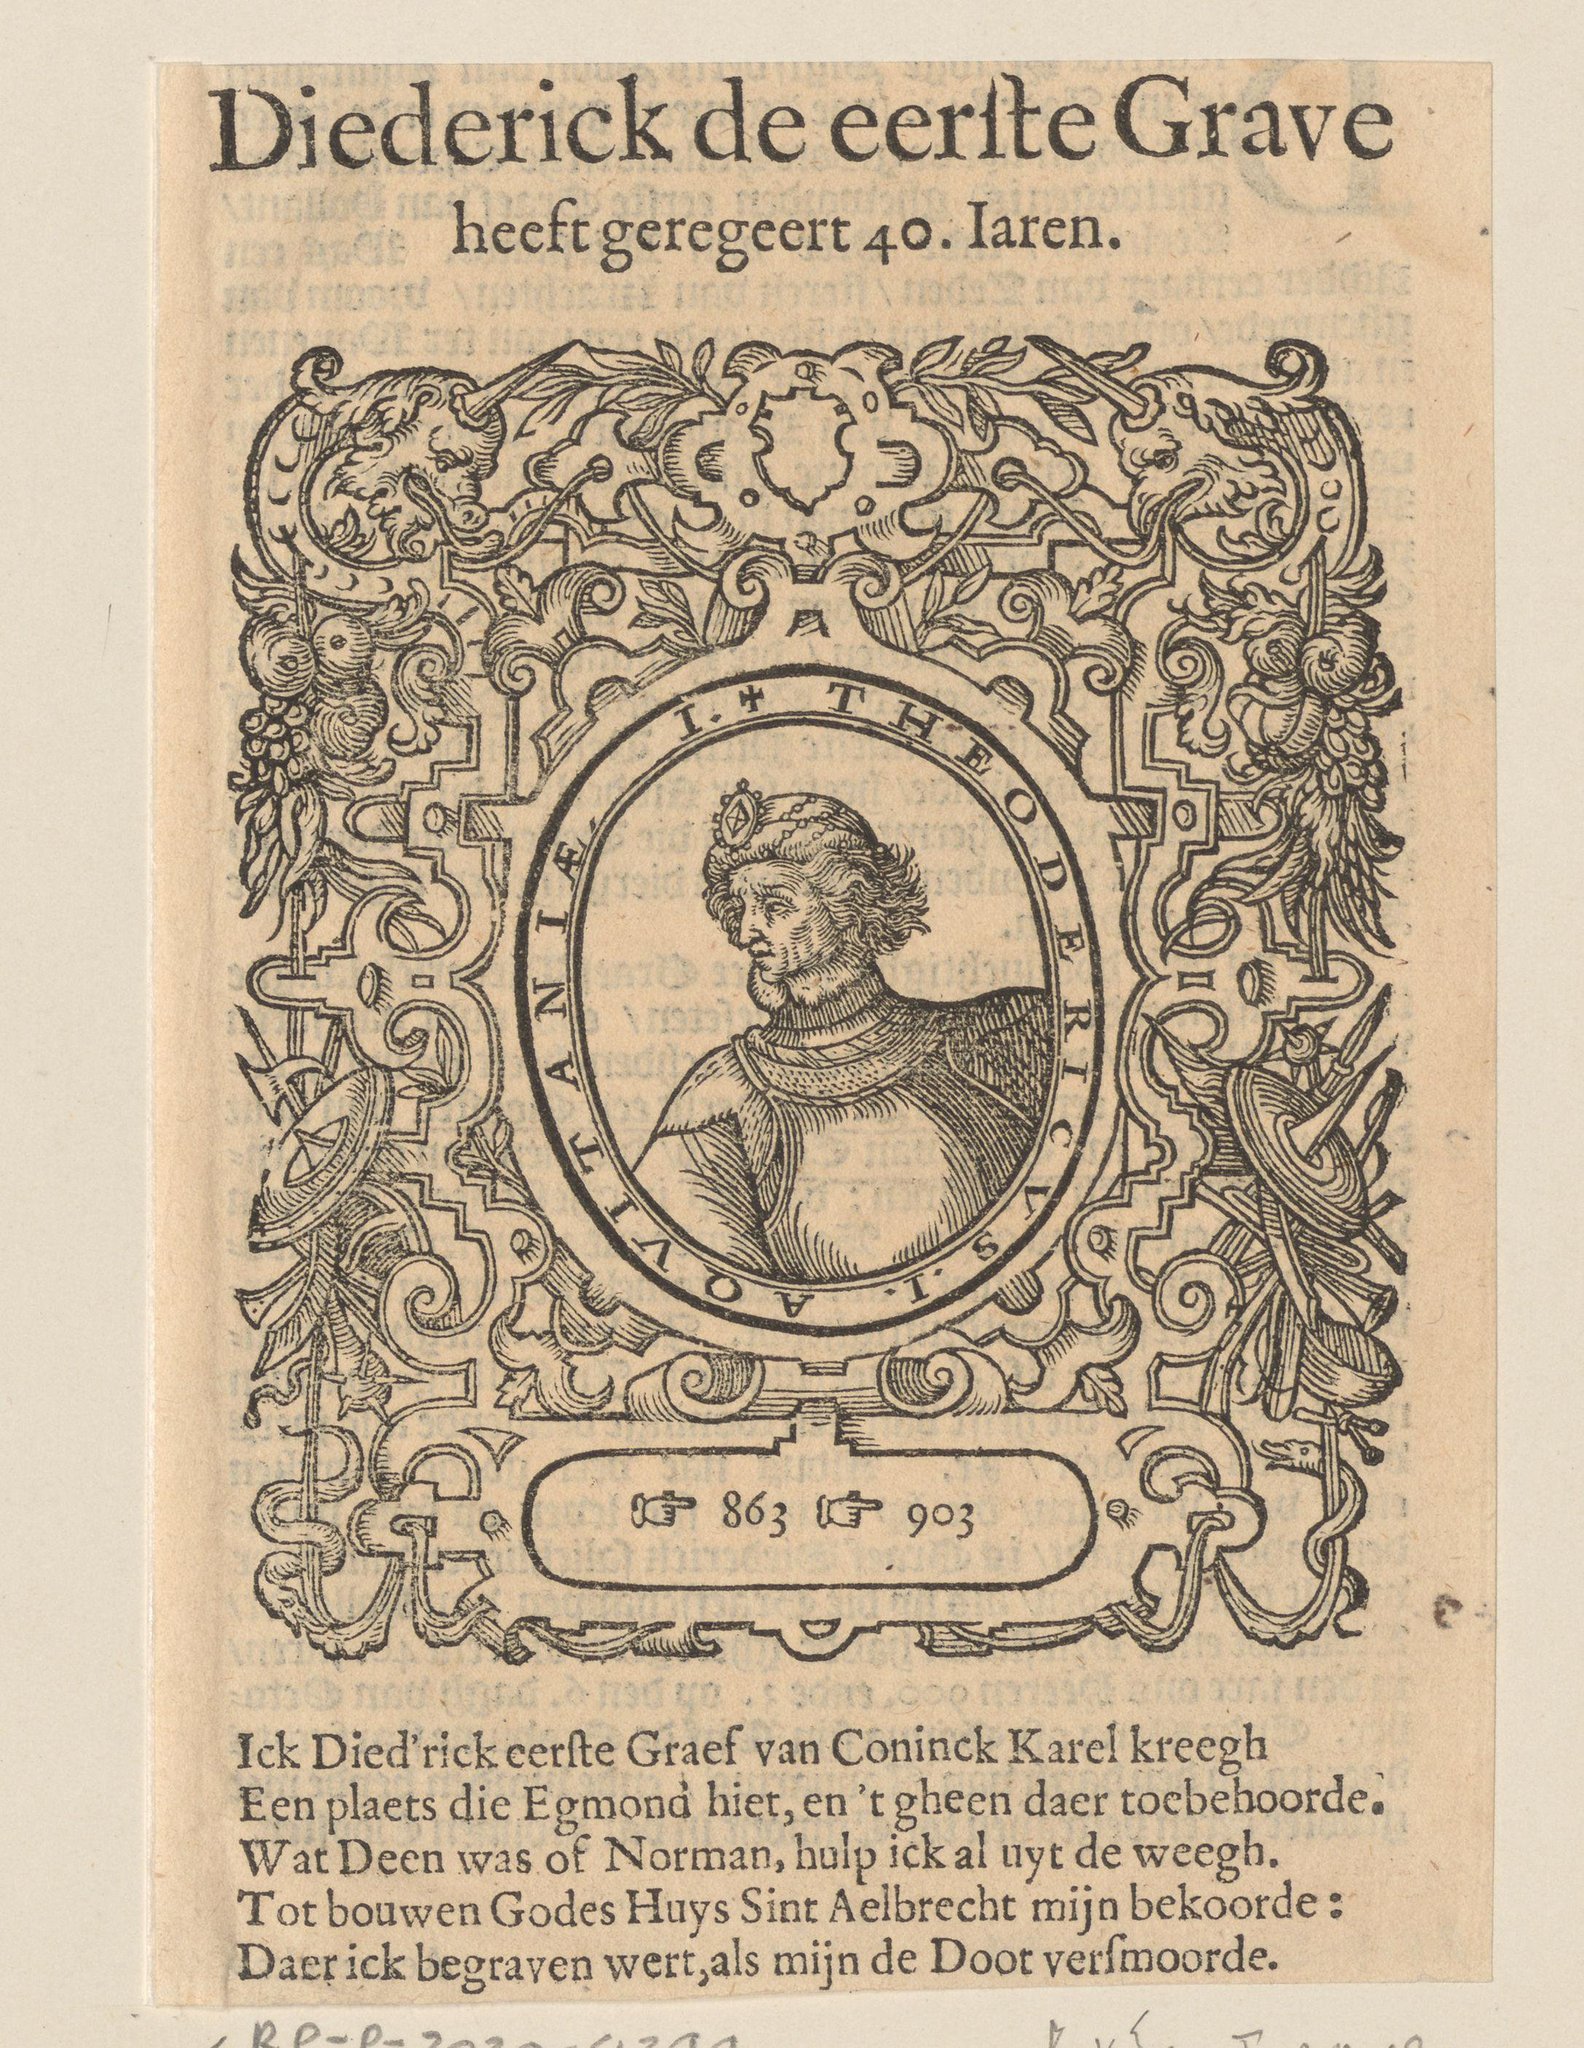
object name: book illustration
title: Portret van Dirk I, graaf van Holland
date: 1636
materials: paper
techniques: letterpress printing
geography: amsterdam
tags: historical persons, head-gear: hat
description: Prent uit: Scriverius, Petrus. Beschrivinge van out Batavien met de antiquiteyten vandien (...). Amsterdam: Jan Evertsz Cloppenburgh, 1636, p. 73.